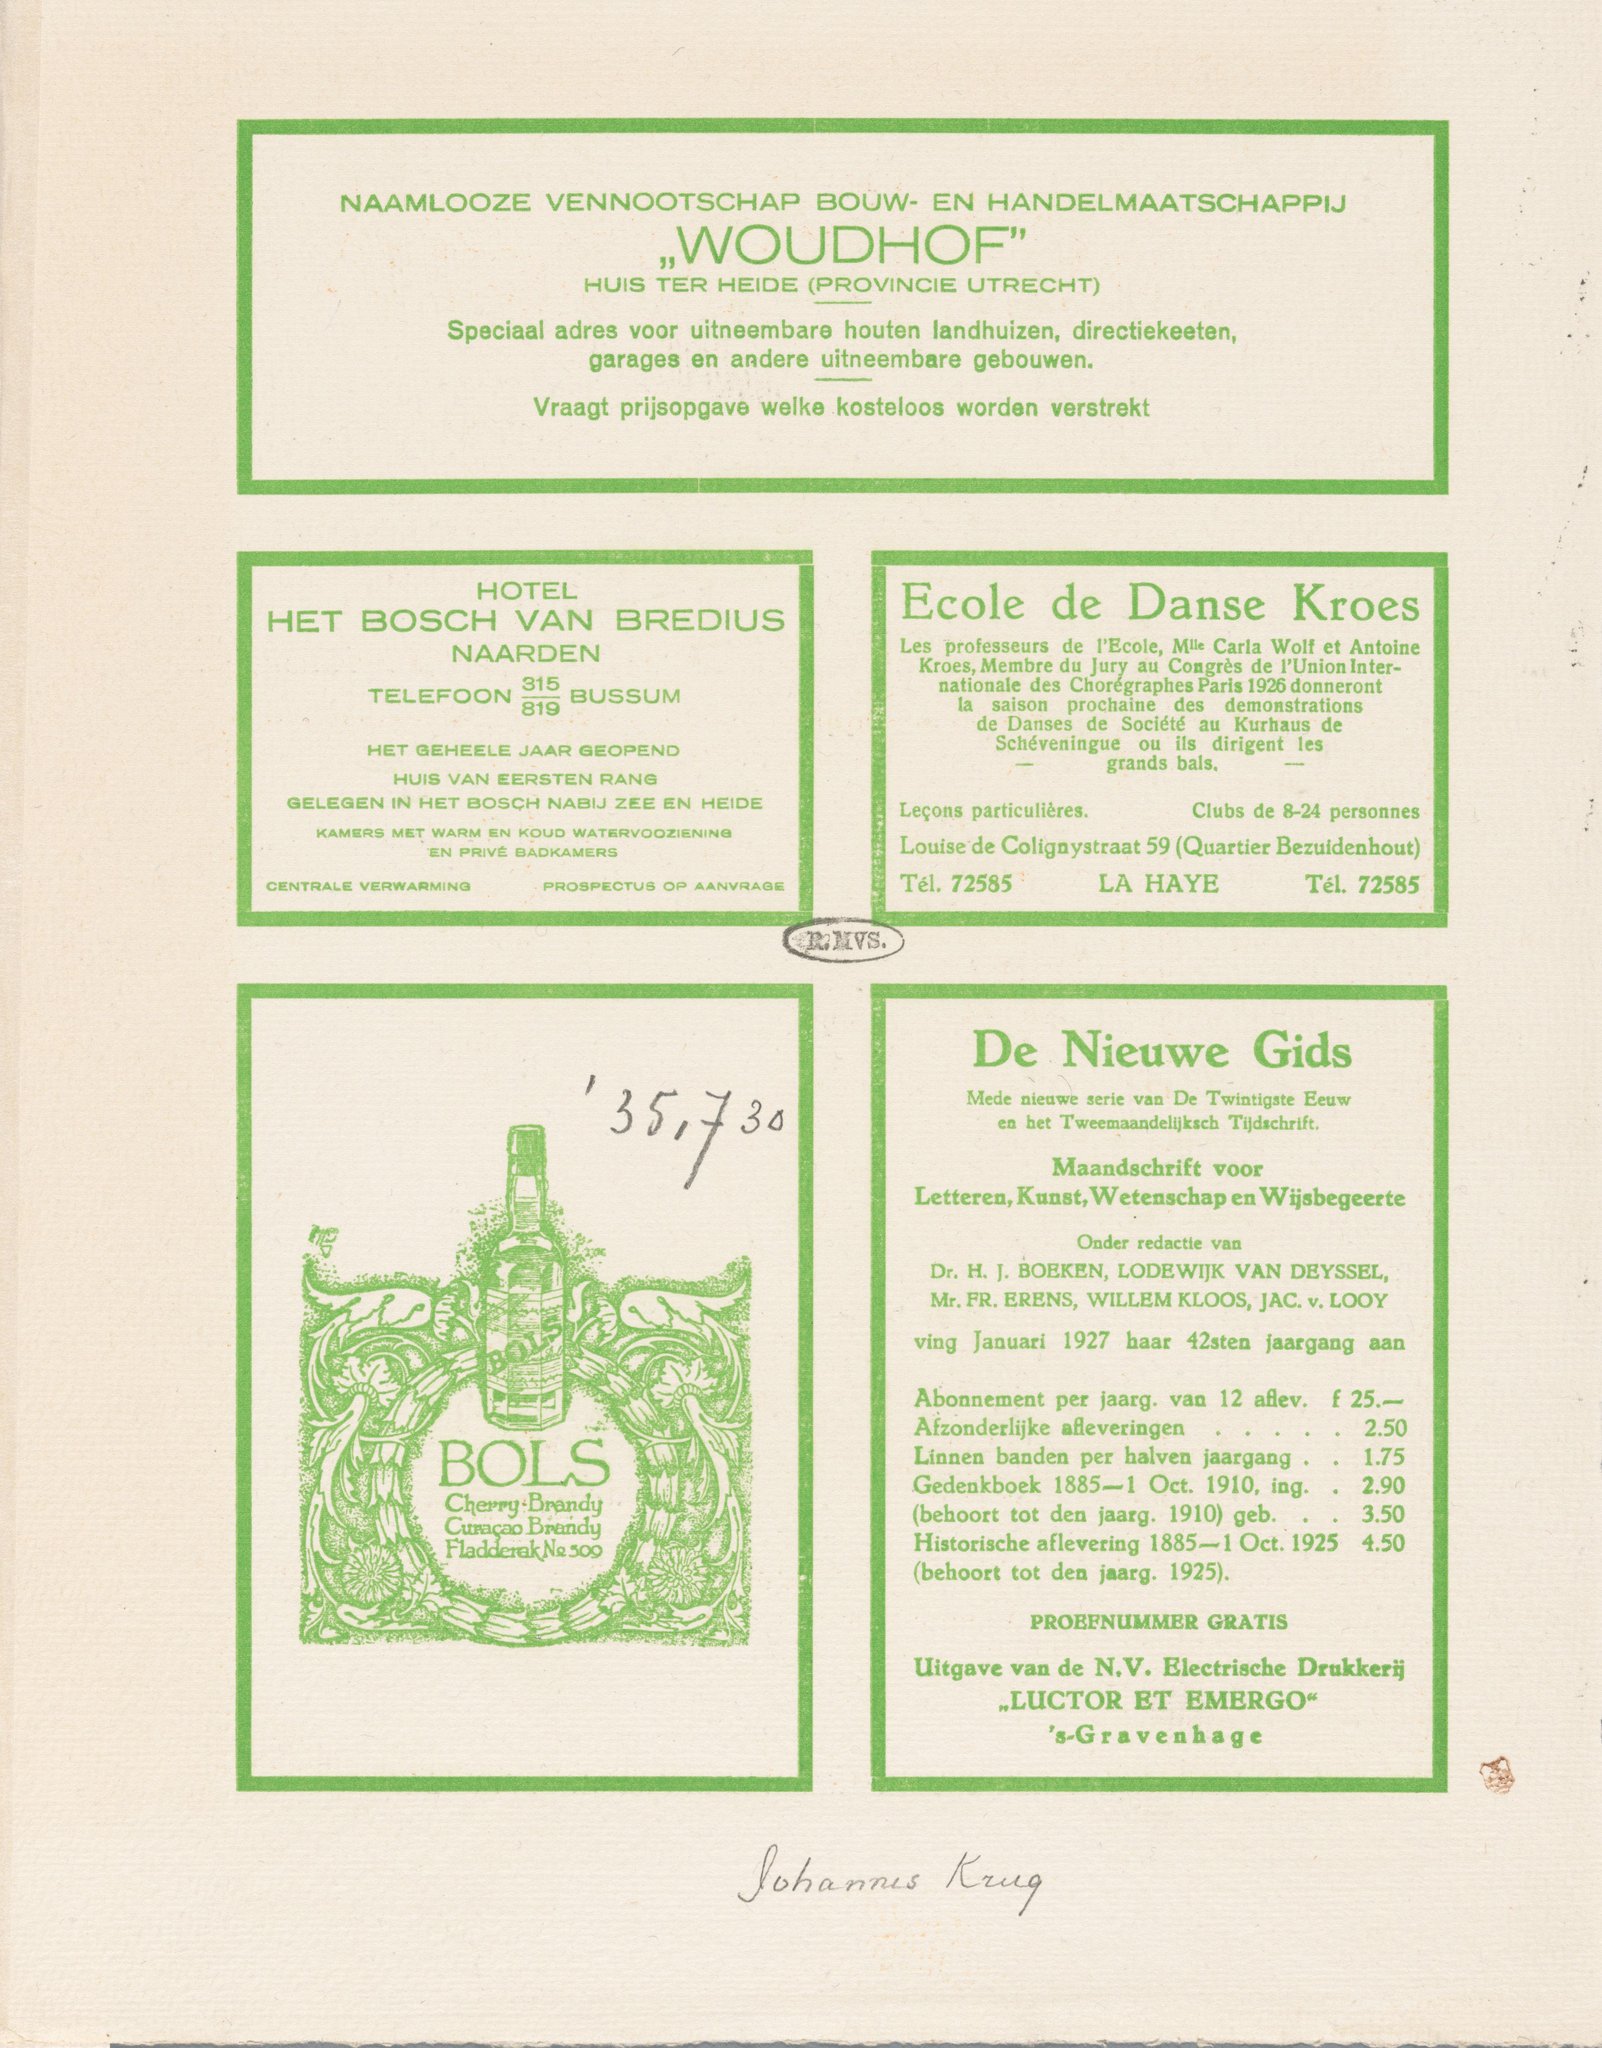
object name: advertisement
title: Ontwerp voor een advertentie van Bols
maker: Anonymous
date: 1907-1927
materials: paper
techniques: woodcut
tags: alcoholic drinks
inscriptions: collector's mark: Lugt 2228, collector's mark: Lugt 2760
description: De tekst 'Cherry Brandy, Curaçao Brandy, Fladderak no. 509', omgeven door een rechthoekig kader dat is opgevuld met plant- en bloemmotieven. Boven in het midden een fles alcoholische drank met het opschrift 'BOLS'.